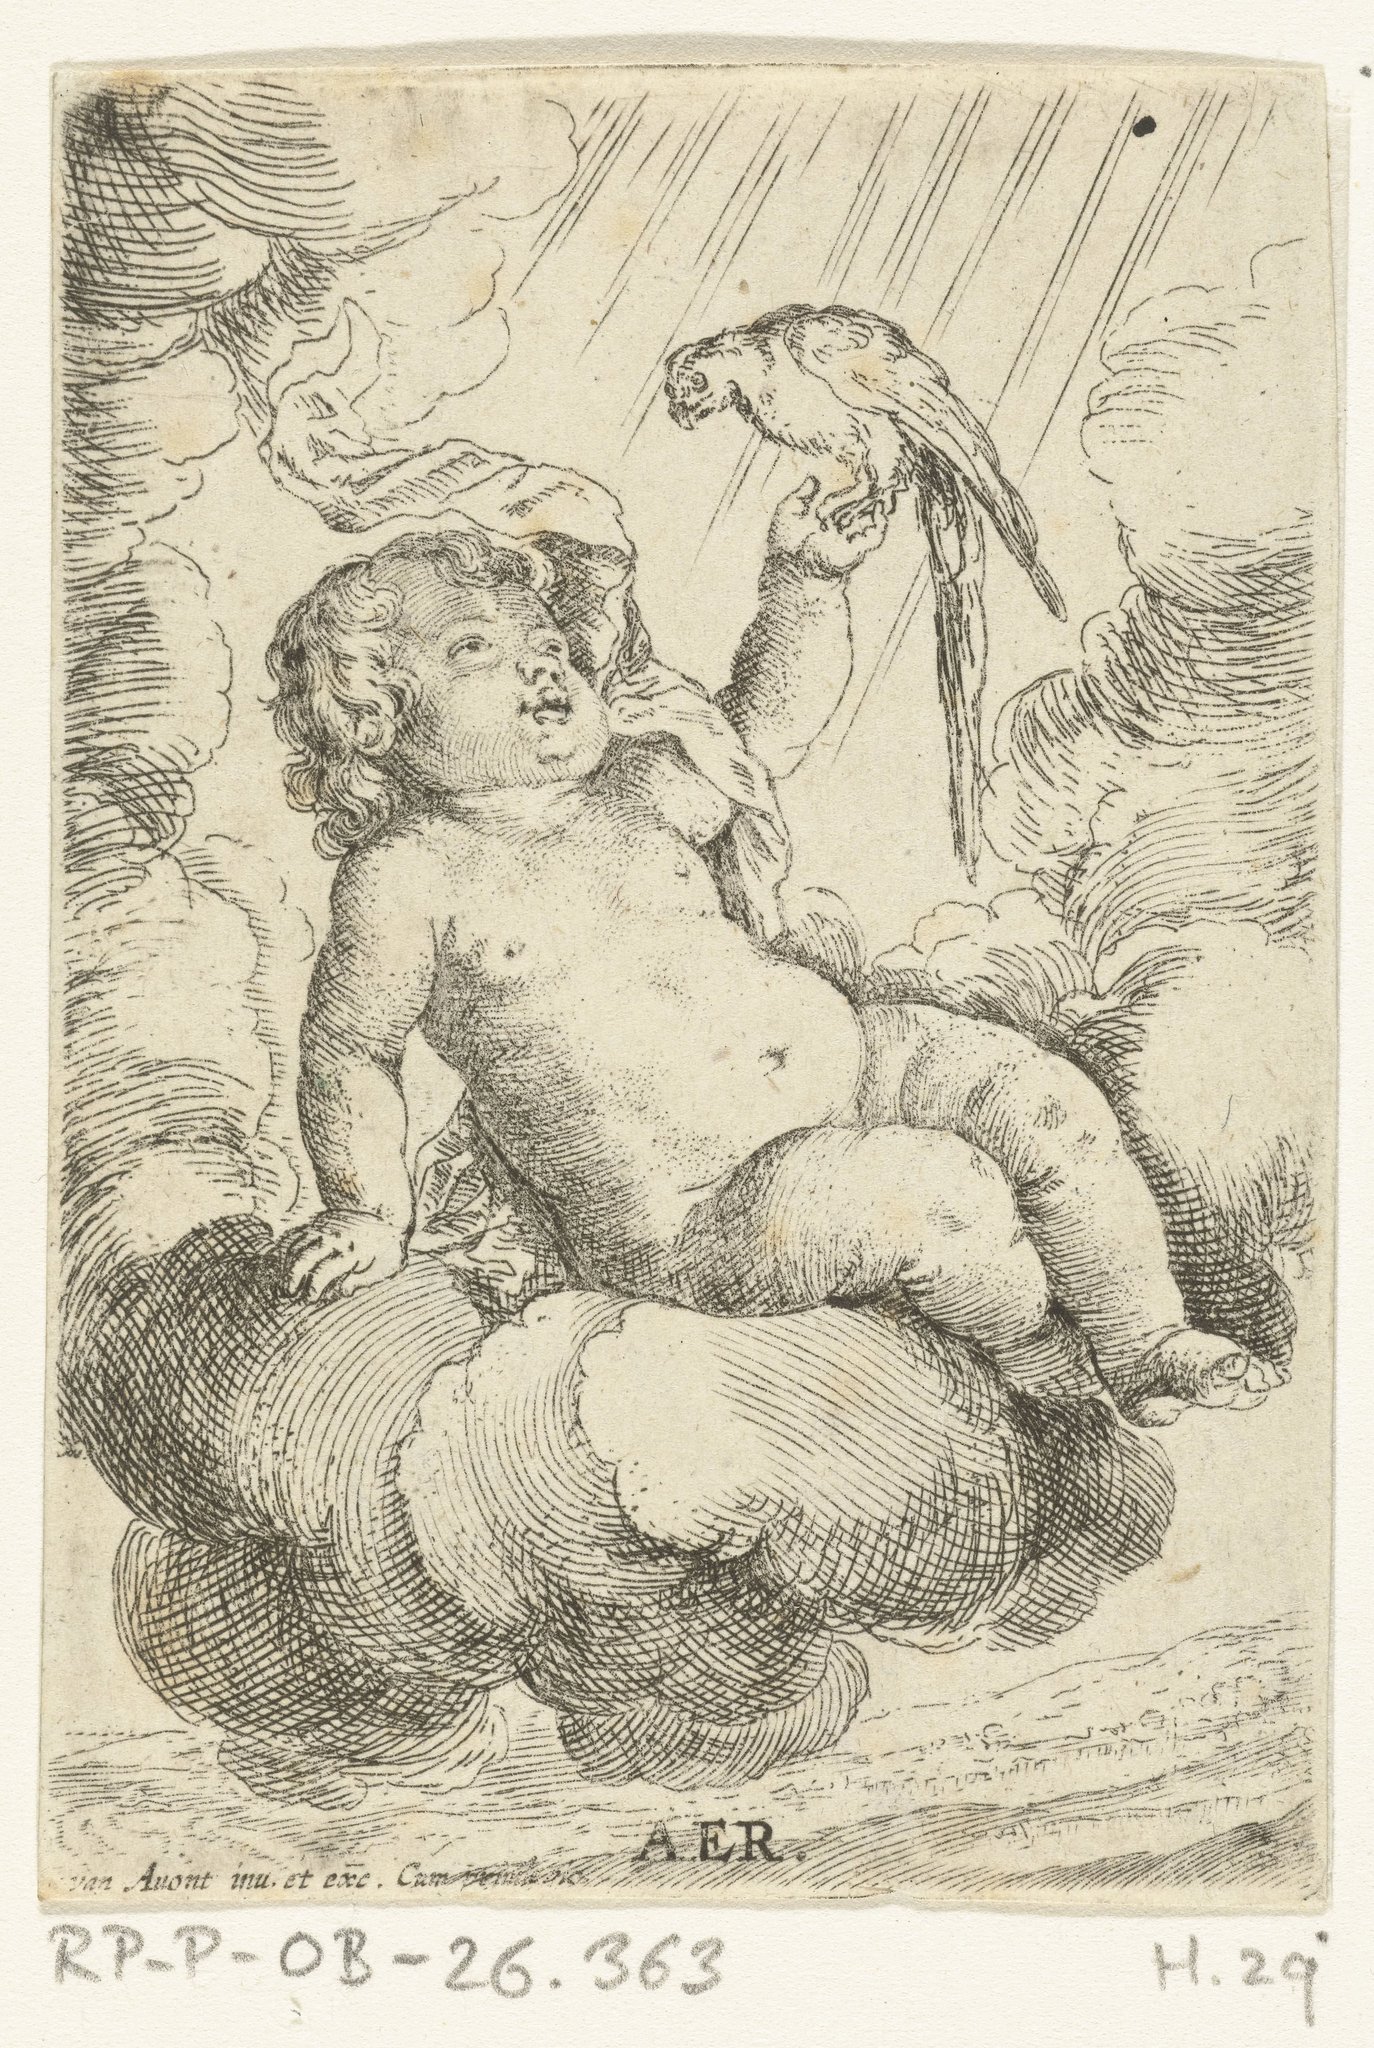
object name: print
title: Lucht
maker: pieter van avont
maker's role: print maker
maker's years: 1600-1652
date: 1622-1652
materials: paper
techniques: engraving, etching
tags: air (one of the four elements)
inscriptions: collector's mark: Lugt 240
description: Een naakt jongetje zit op een wolk en houdt een papegaai in zijn hand. Prent uit een serie van vier prenten die de vier elementen verbeelden.